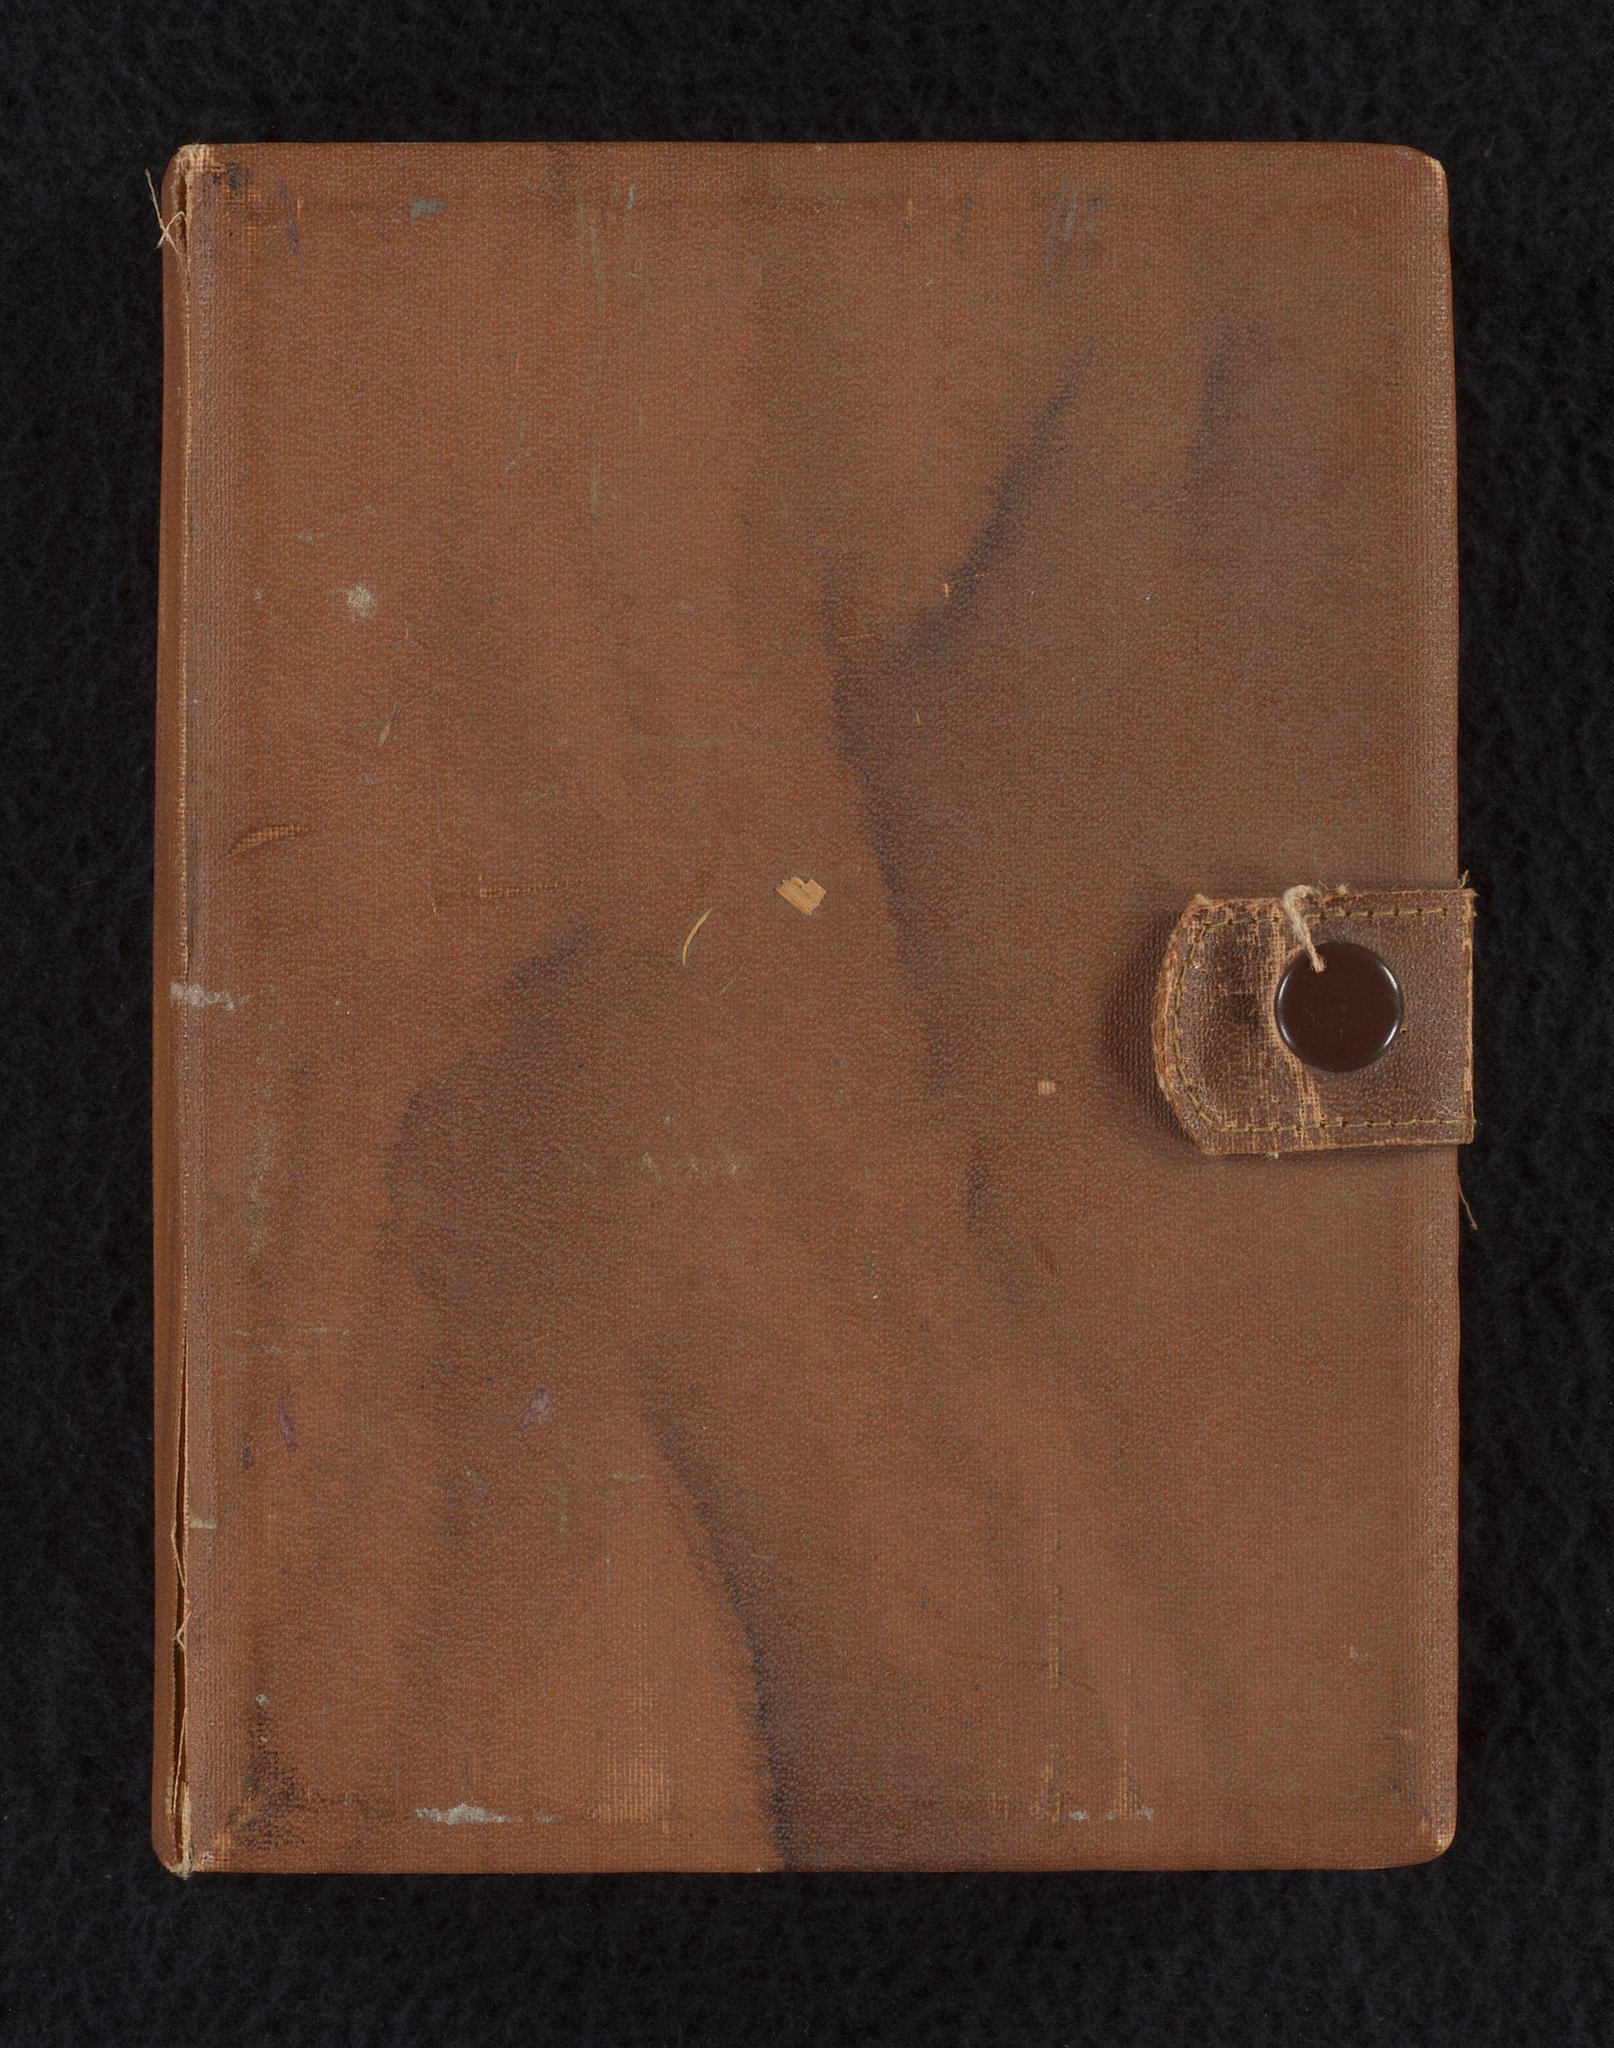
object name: photograph album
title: Fotoalbum met vakantiefoto's Lenzerheide, 1934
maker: else wachenheimer-moos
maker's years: 1895-1944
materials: cardboard, linen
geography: switzerland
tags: leiden, isabel wachenheimer-elon, the family travelling, on holiday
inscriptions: inscription: ‘Lenzerheide Januar - Februar 1934’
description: Dit object is onderdeel van de nalatenschap van Isabel Elon-Wachenheimer (1928-2010). Tot haar overlijden behoorde het samen met de andere objecten uit de nalatenschap tot haar privédomein van Isabel Wachenheimer. In die particuliere context zijn deze objecten tezamen en individueel aandenkens - aan de jeugd, ouders en familie van Isabel Wachenheimer vóór en tijdens de Shoah en aan haar leven na de Tweede Wereldoorlog. Isabel Wachenheimer, die van juni 1943 tot mei 1945 gevangen zat in Kamp Westerbork, Theresienstadt, Auschwitz, Lenzing a/d Oberdonau (een buitenkamp van Mauthausen), overleefde de Shoah. Haar ouders – Eugène Wachenheimer en Else Wachenheimer-Moos - werden op 14 oktober 1944 in Auschwitz-Birkenau vermoord.